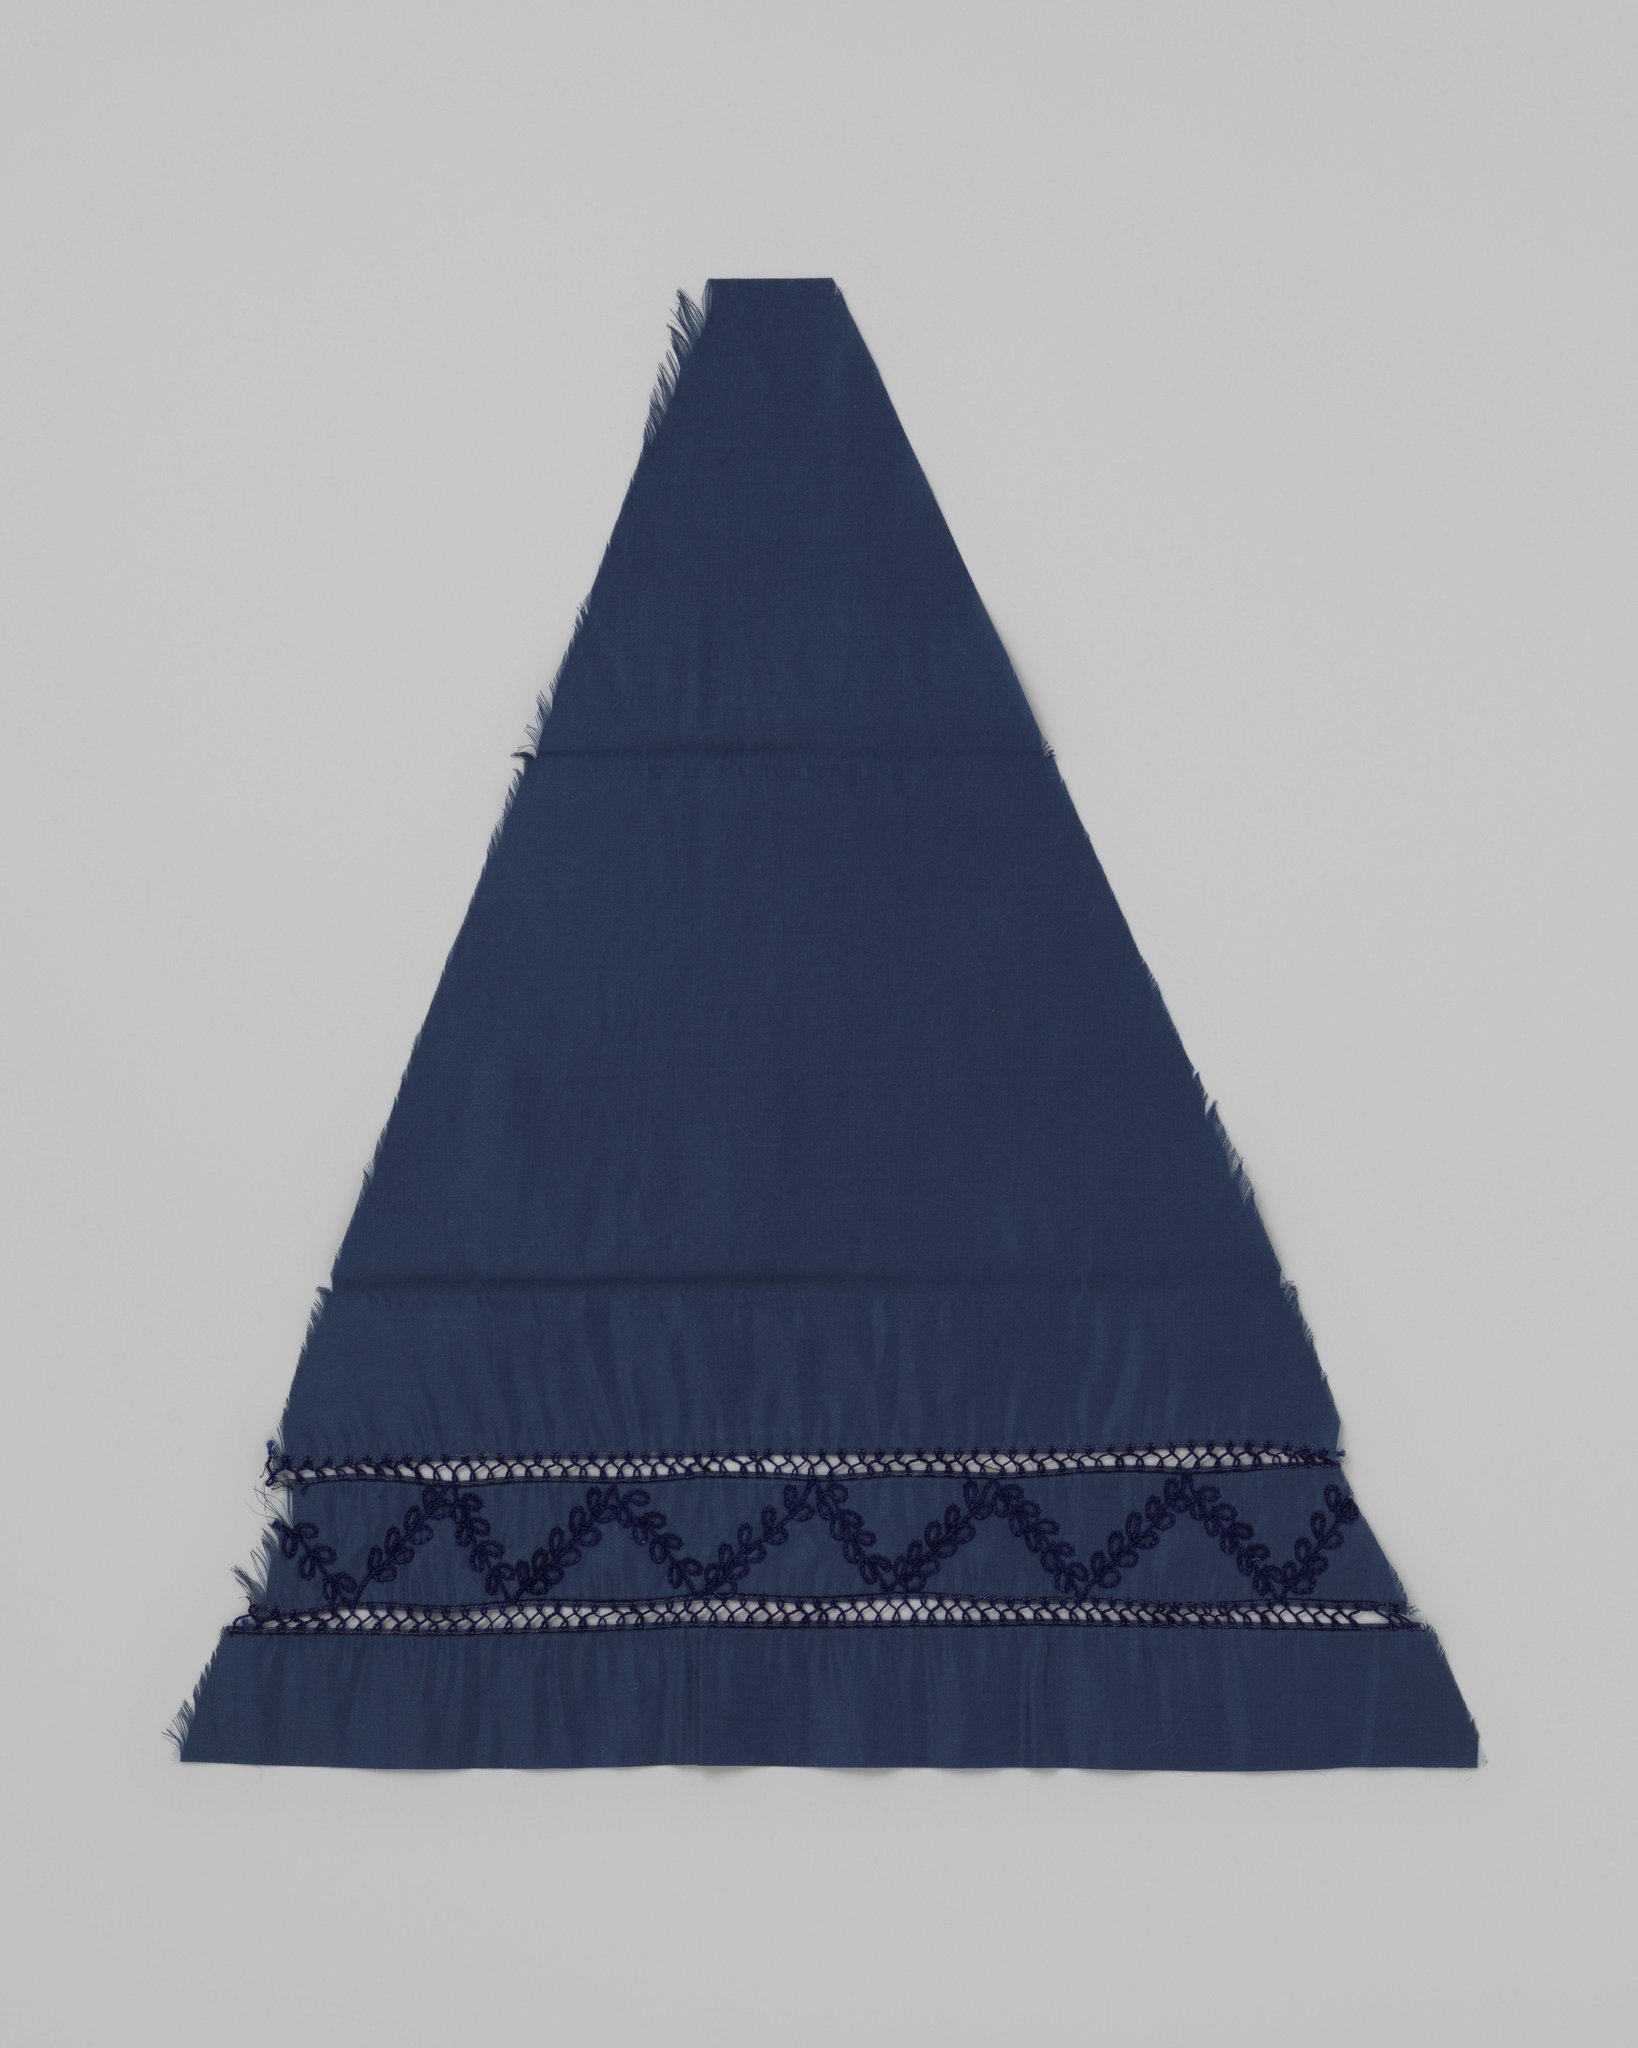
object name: parasoldek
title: Sector van een parasoldek van donkerblauwe katoen, versierd met borduurwerk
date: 1885-1900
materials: cotton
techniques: embroidered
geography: nijmegen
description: Sector van een parasoldek van donkerblauwe katoen, versierd met borduurwerk. Het borduurwerk bestaat uit twee rijen stiksteken doorgeregen met een flanelsteek, waartussen een slingerende bladrank. Aan het dek is een etiket bevestigd met een metalen klem.